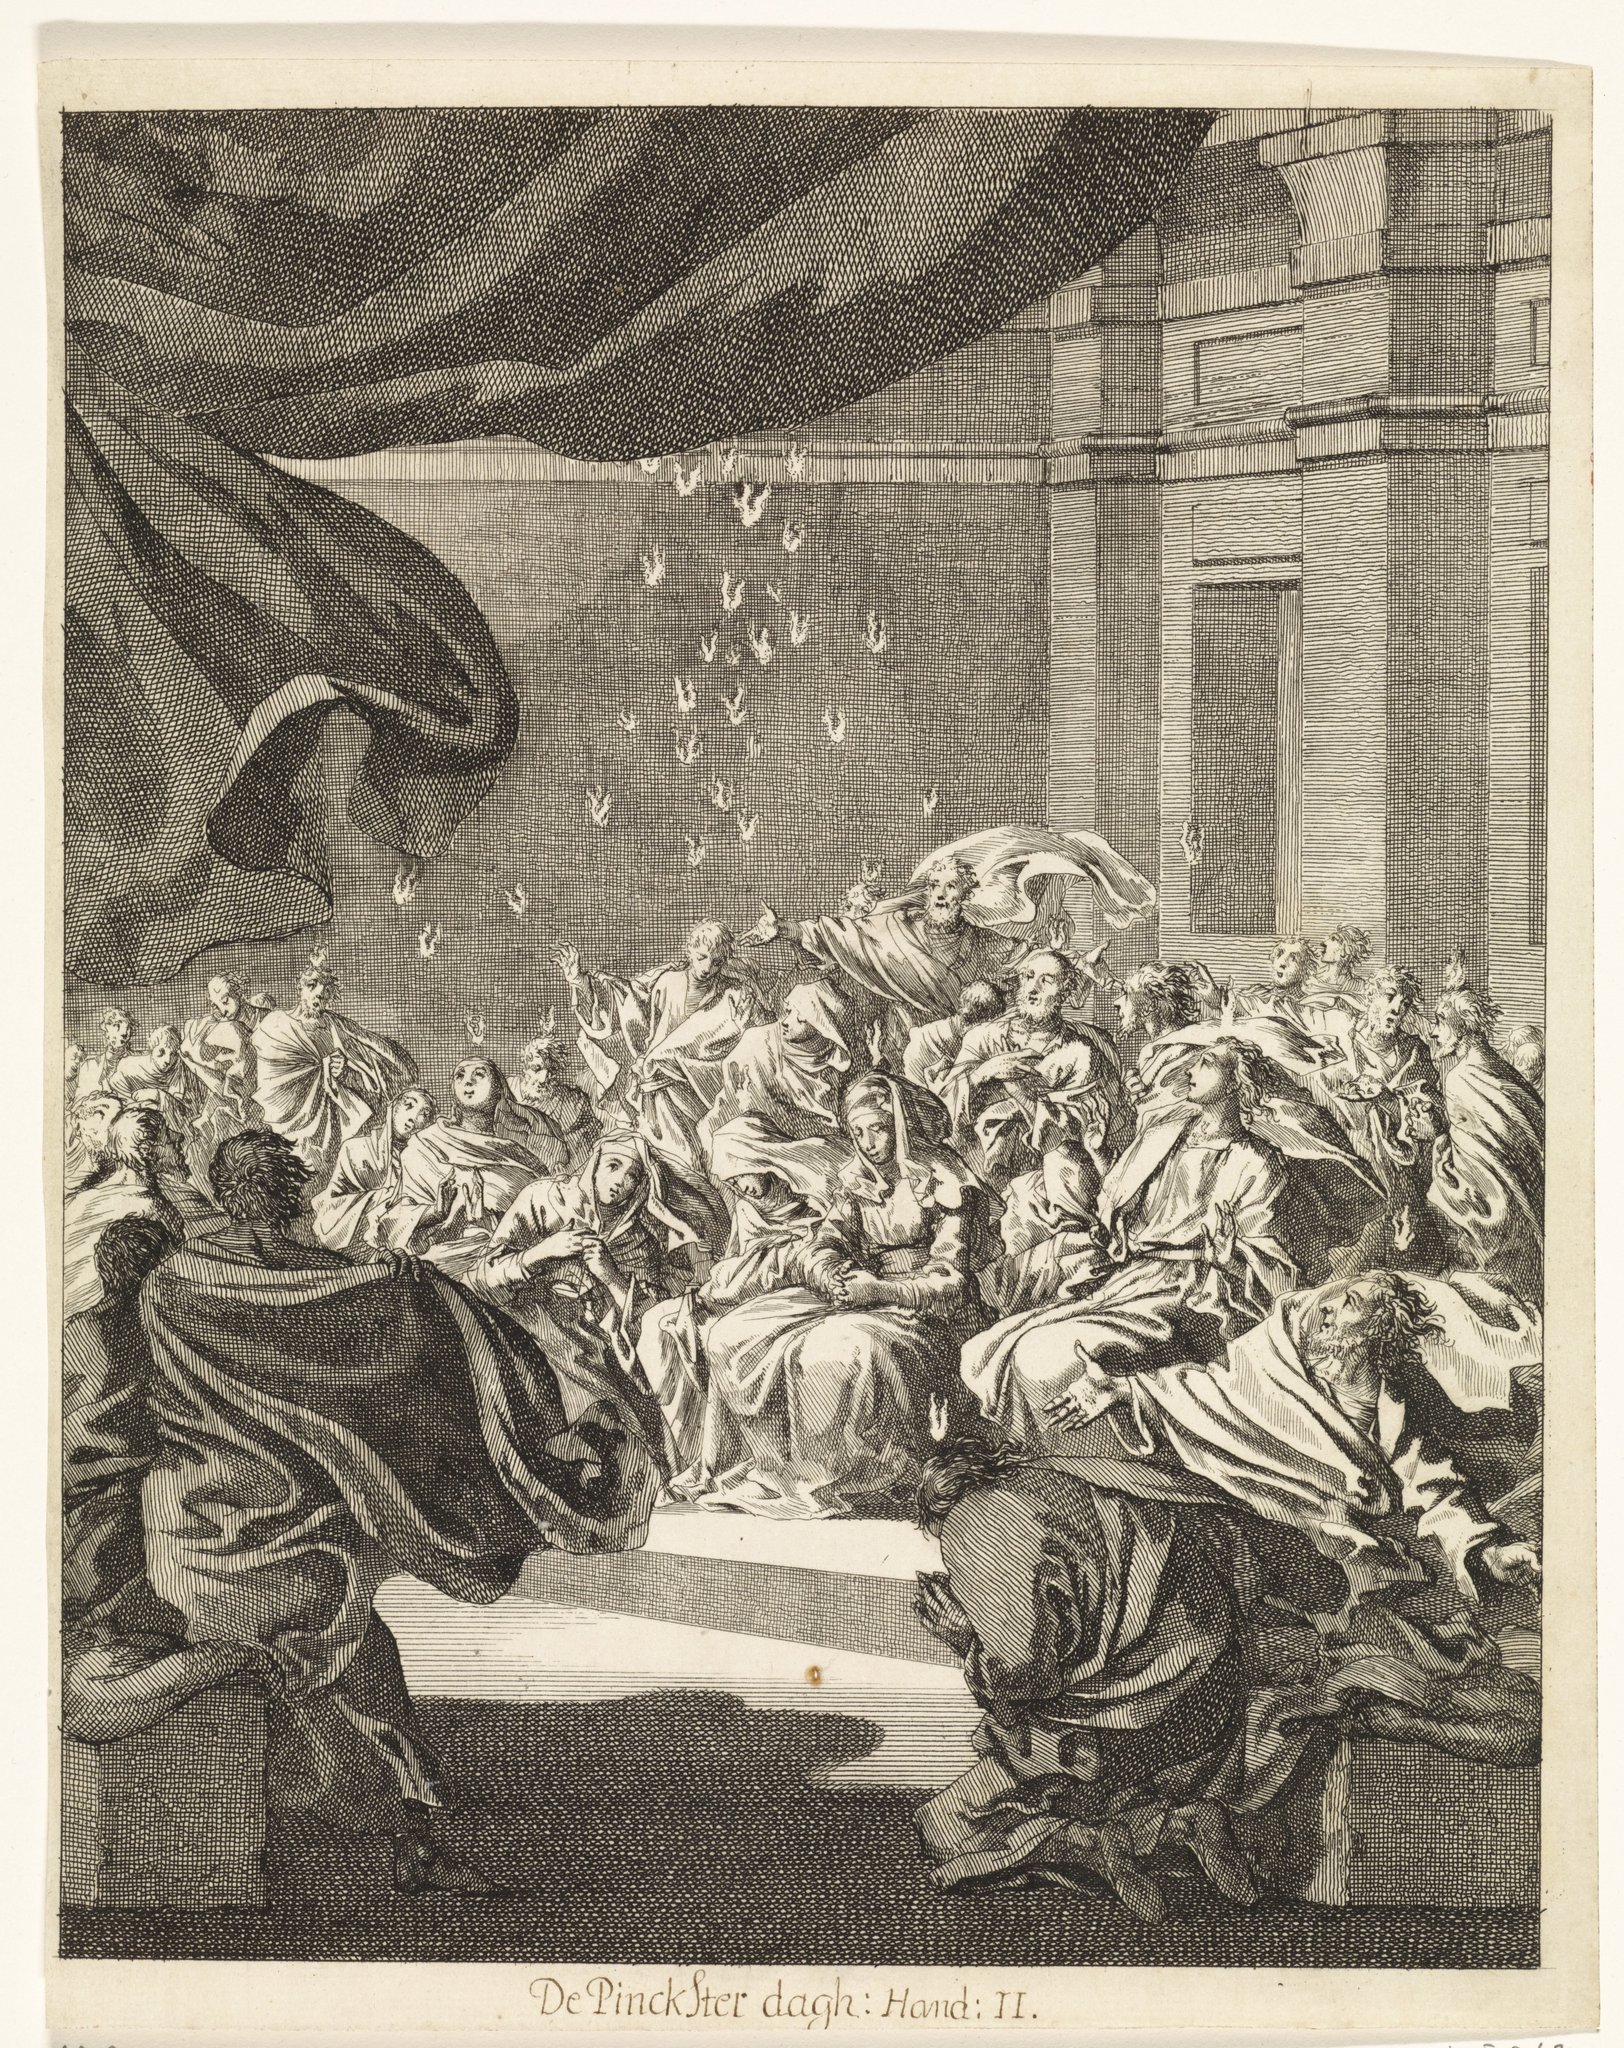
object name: print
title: Uitstorting van de Heilige Geest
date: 1708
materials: paper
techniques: etching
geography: amsterdam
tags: pentecost: the holy ghost descends upon (mary and) the apostles, sometimes paul and/or representatives of the nations present (acts 2:1-4) (+ angel(s))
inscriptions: collector's mark: Lugt 2228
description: Proefdruk van een prent welke is opgenomen als illustratie in: Historiae Celebriores Veteris Testamenti. Christoph Weigel, 1708.